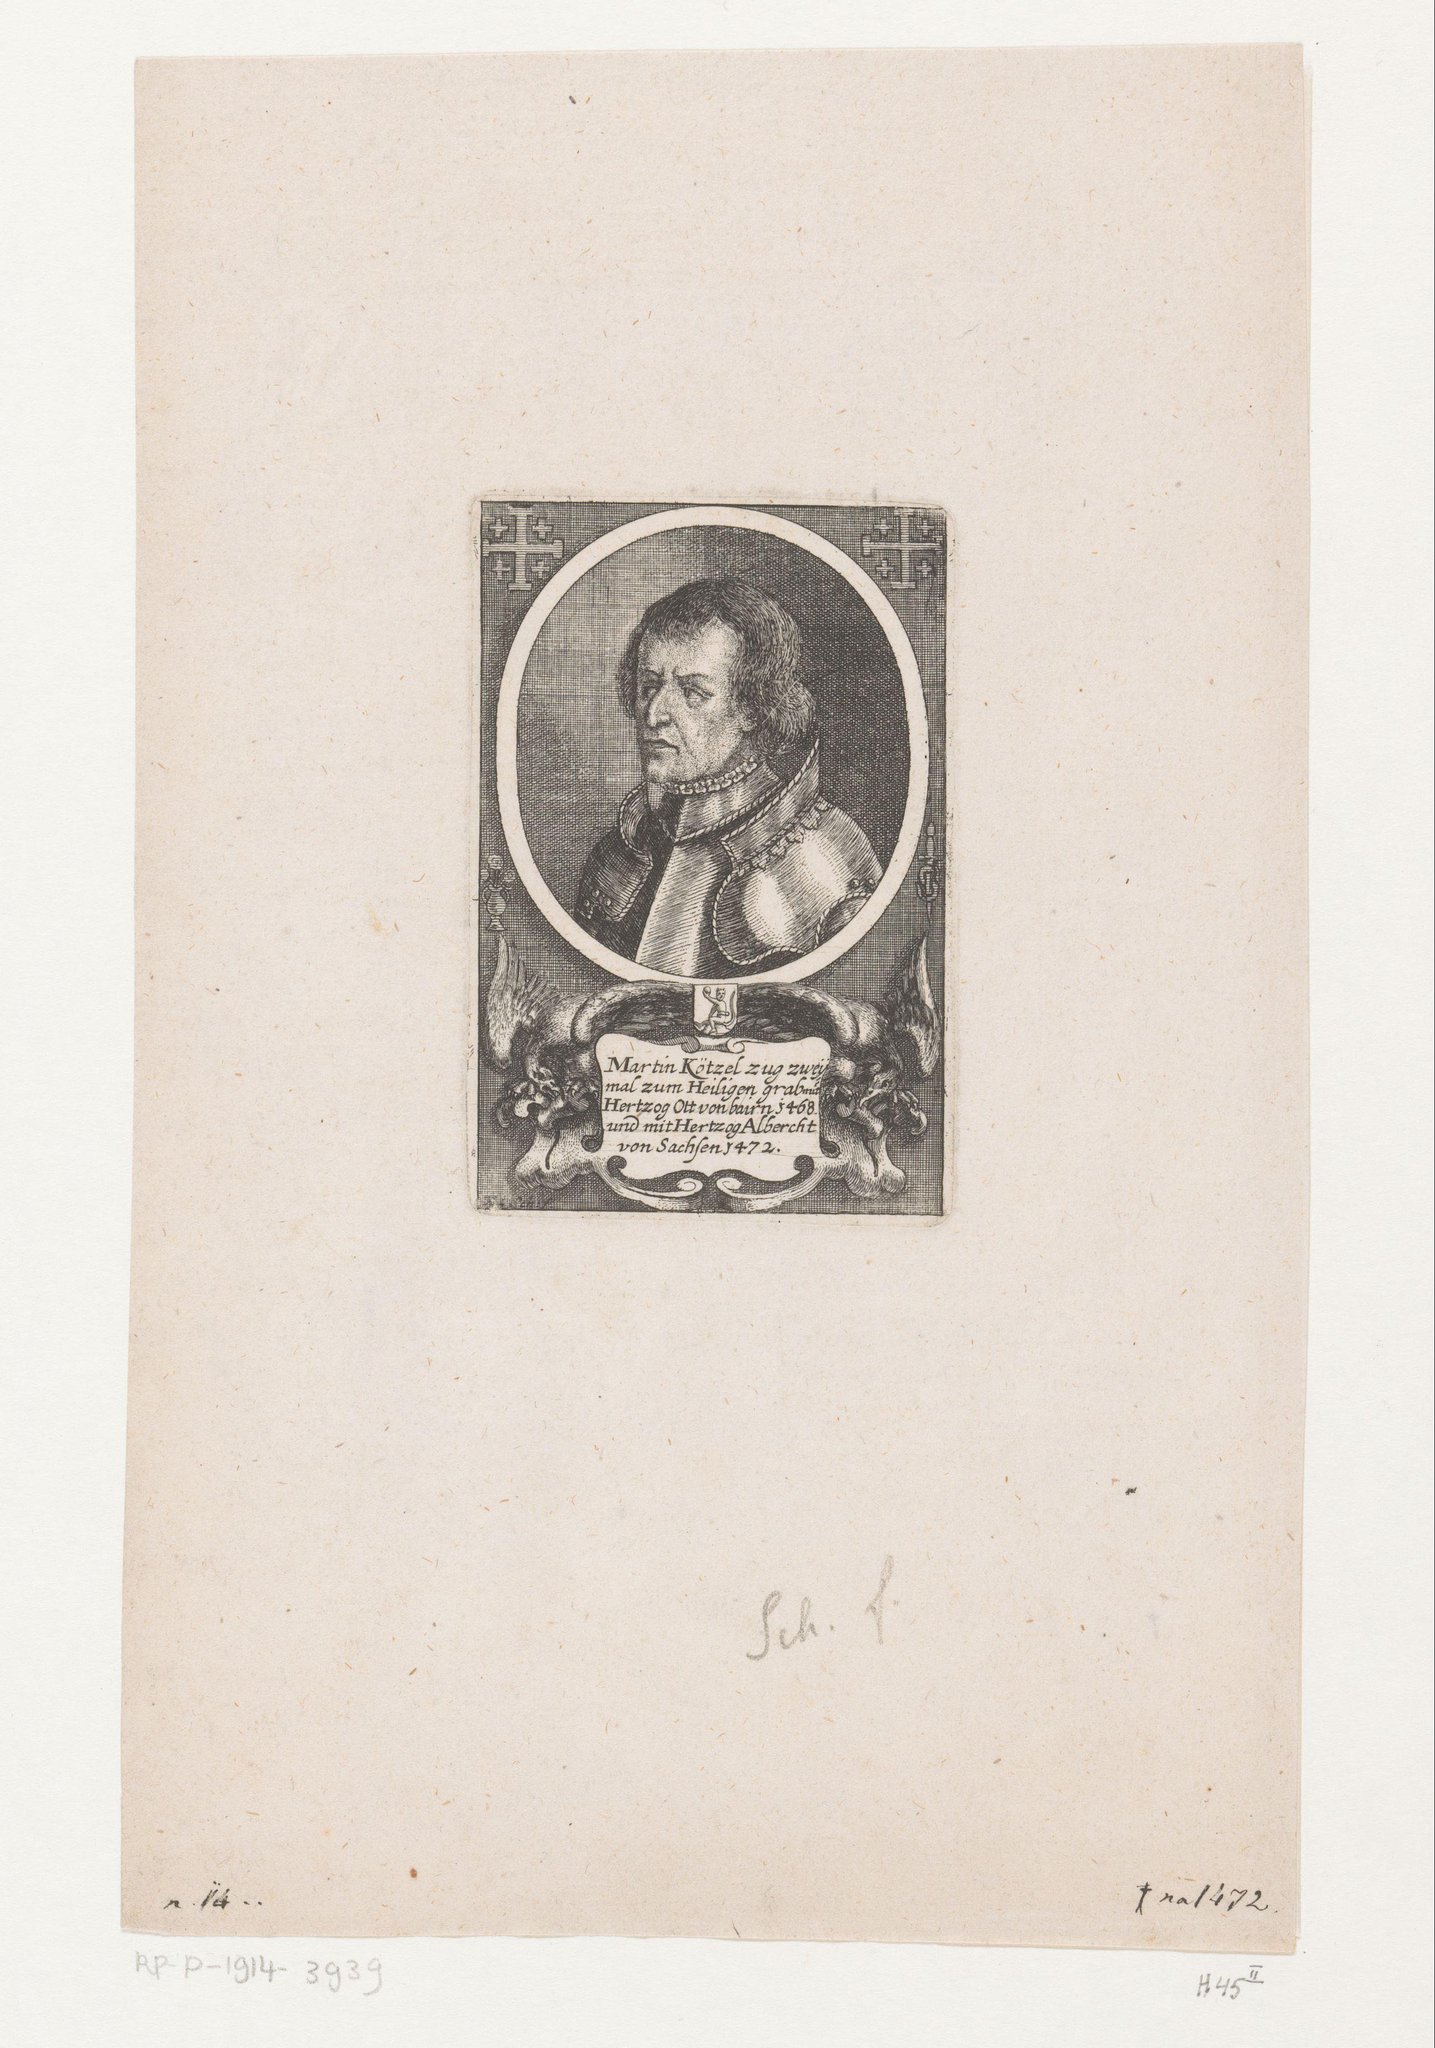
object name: print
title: Portret van Martin Ketzel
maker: johann jacob schollenberger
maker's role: print maker, publisher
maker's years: 1646-1689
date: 1656-1689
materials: paper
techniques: etching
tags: pilgrim(s), historical persons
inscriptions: collector's mark: Lugt 2228